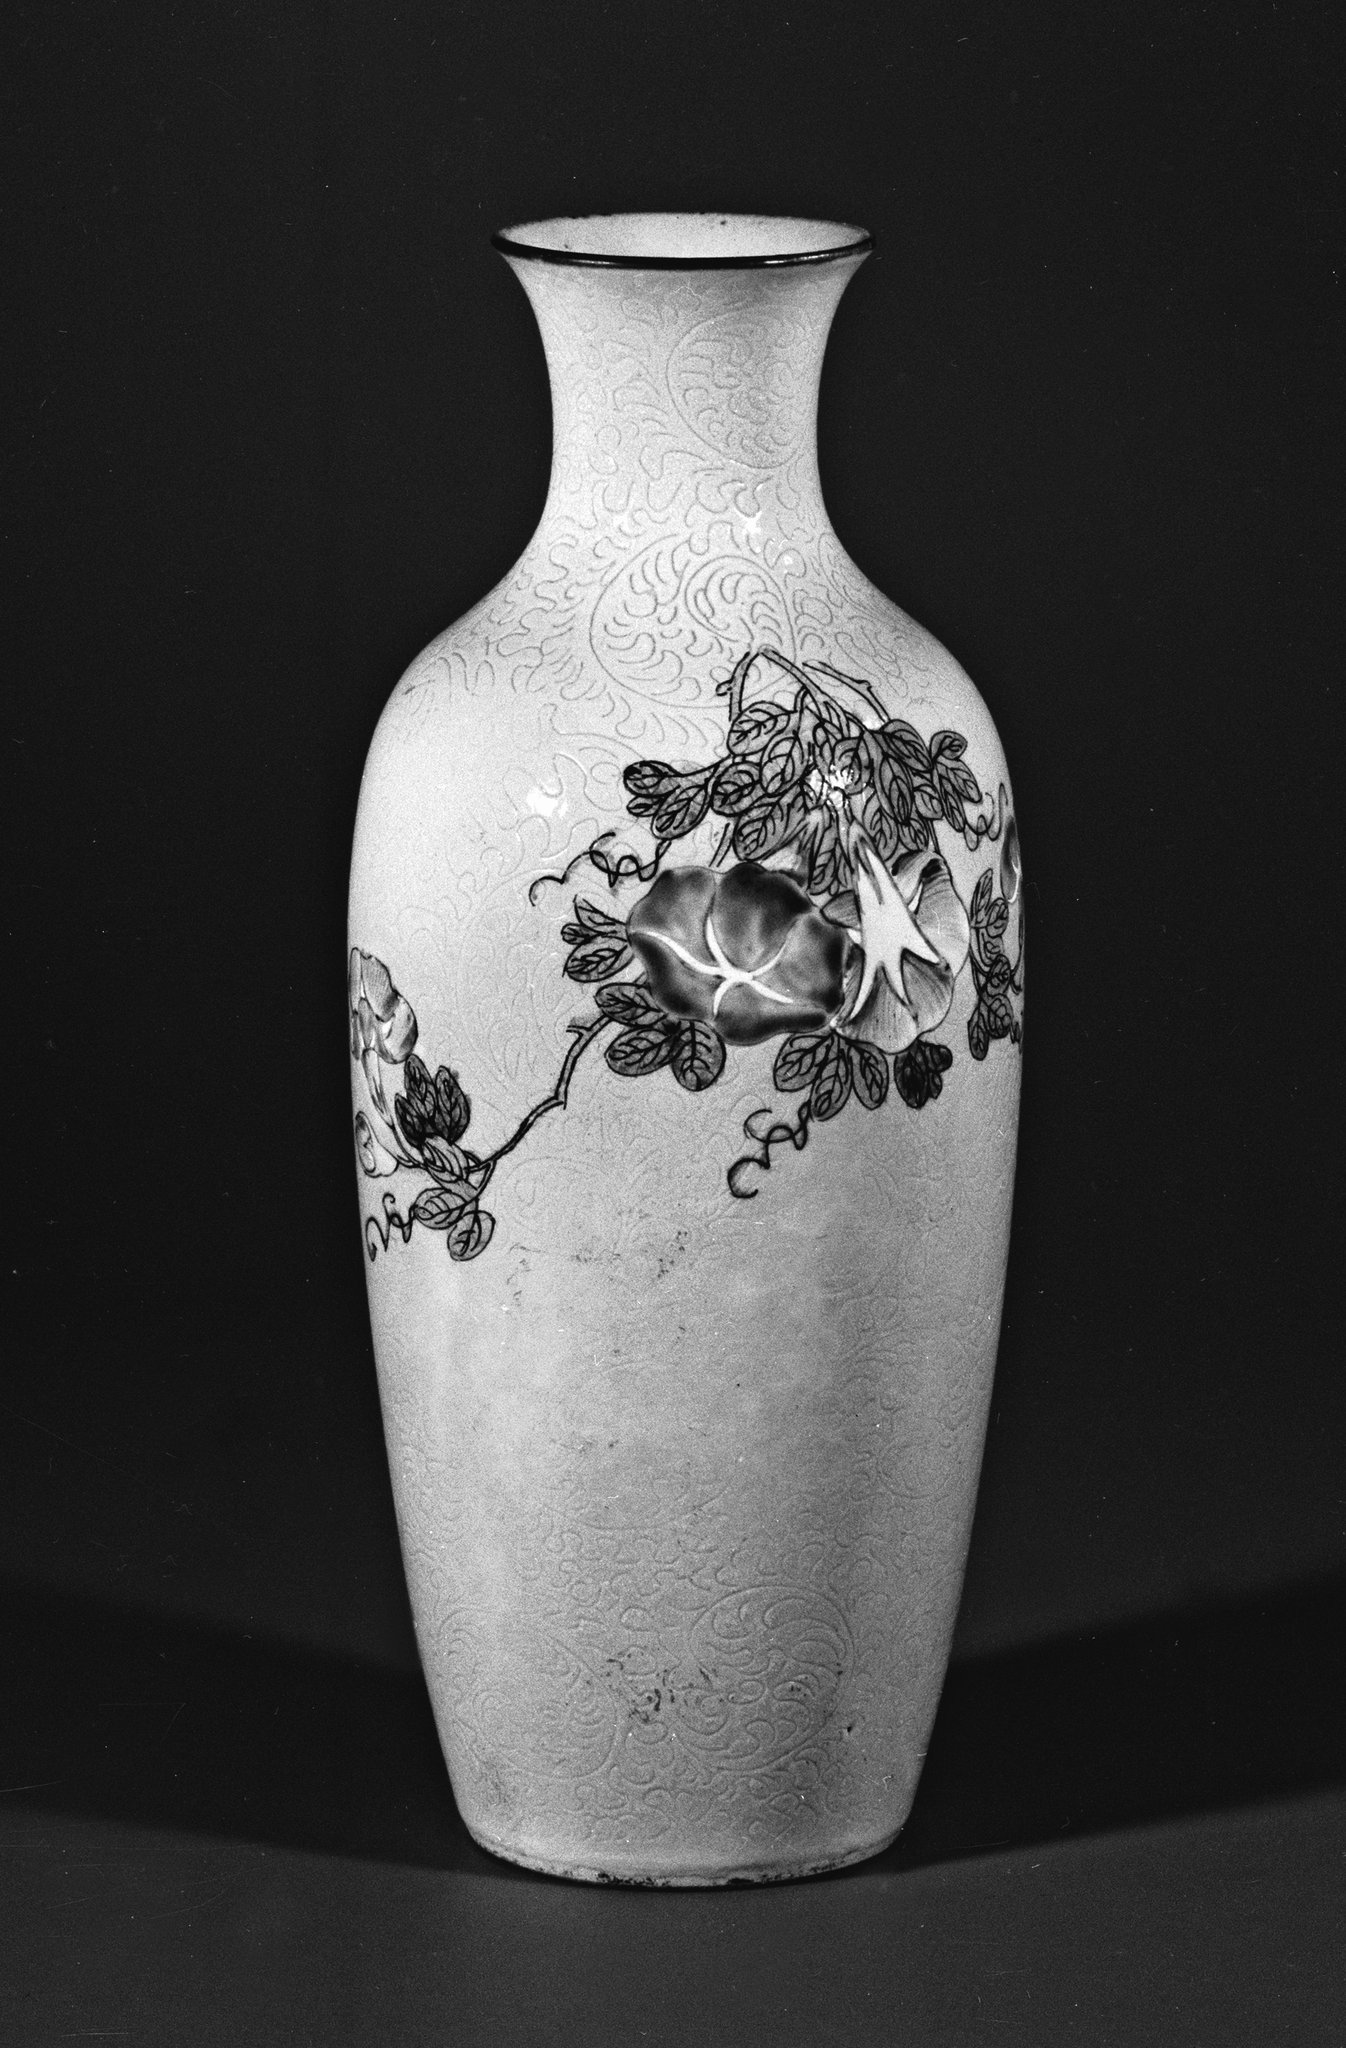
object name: vase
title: Vase with flowers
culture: chinese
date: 1801-1900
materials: enamel, porcelain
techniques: overglaze, painting, polychrome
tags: flowers,leaves